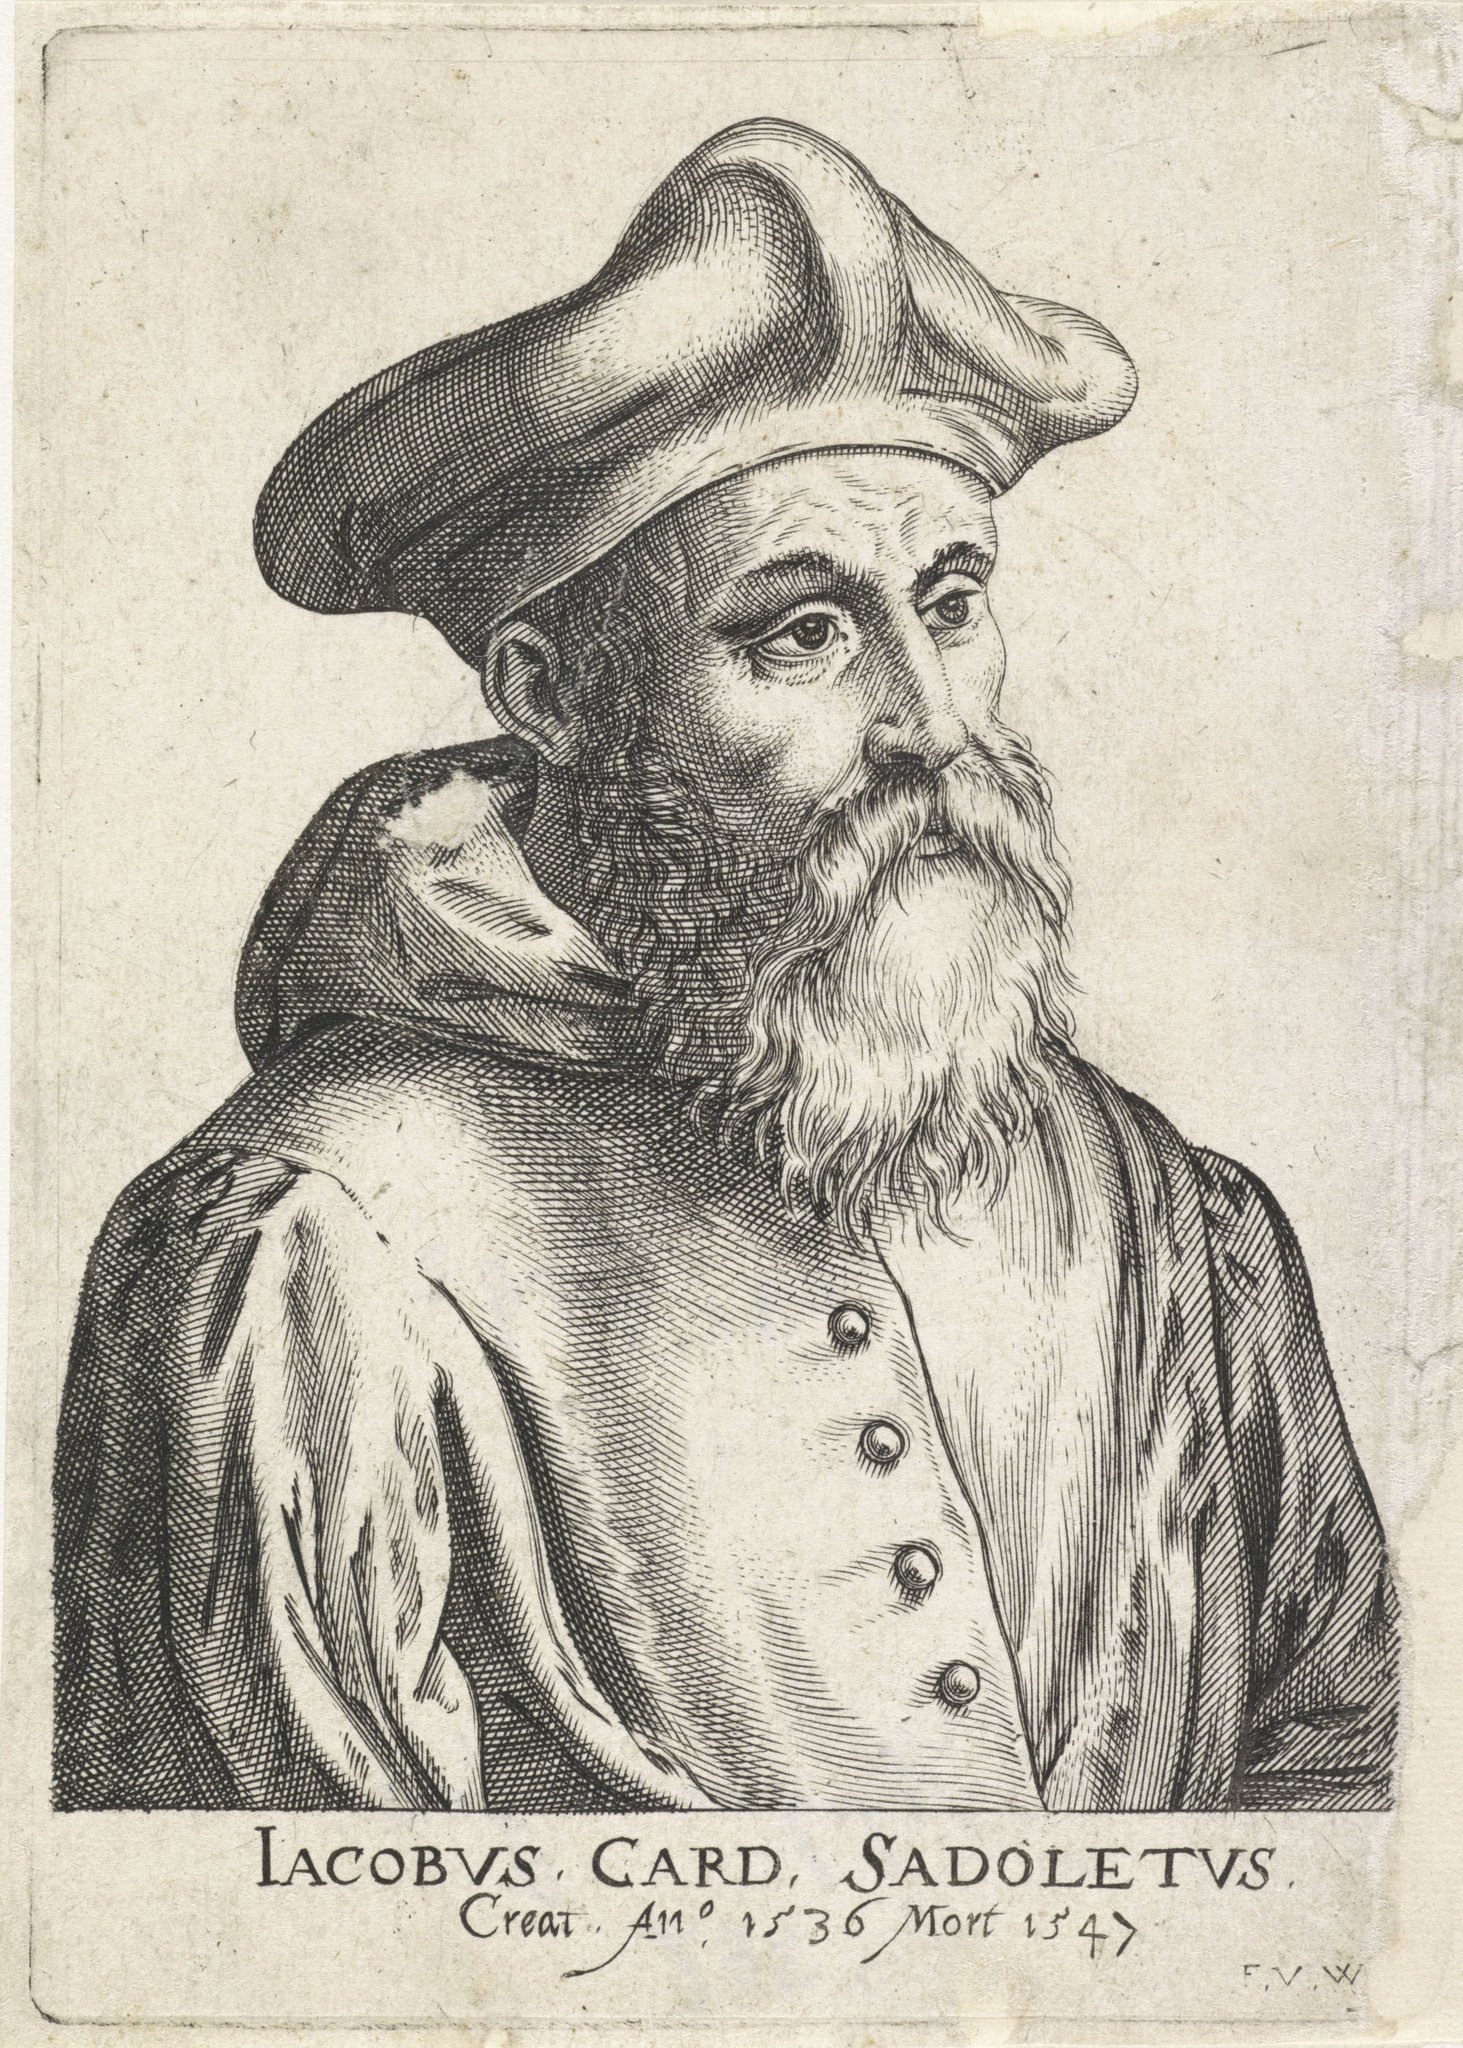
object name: print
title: Portret van de Italiaanse kardinaal Jacopo Sadoleto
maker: frans van den wijngaerde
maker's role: print maker, publisher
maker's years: 1614-1679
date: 1644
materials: paper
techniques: engraving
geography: antwerp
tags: rome, cardinal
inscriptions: collector's mark: Lugt 2228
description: Prent gebruikt in: Albi, Henri. Eloges historiques des Cardinaux illustres François et etrangers mis en parallele. Parijs: Anthoine de Cay, 1644.